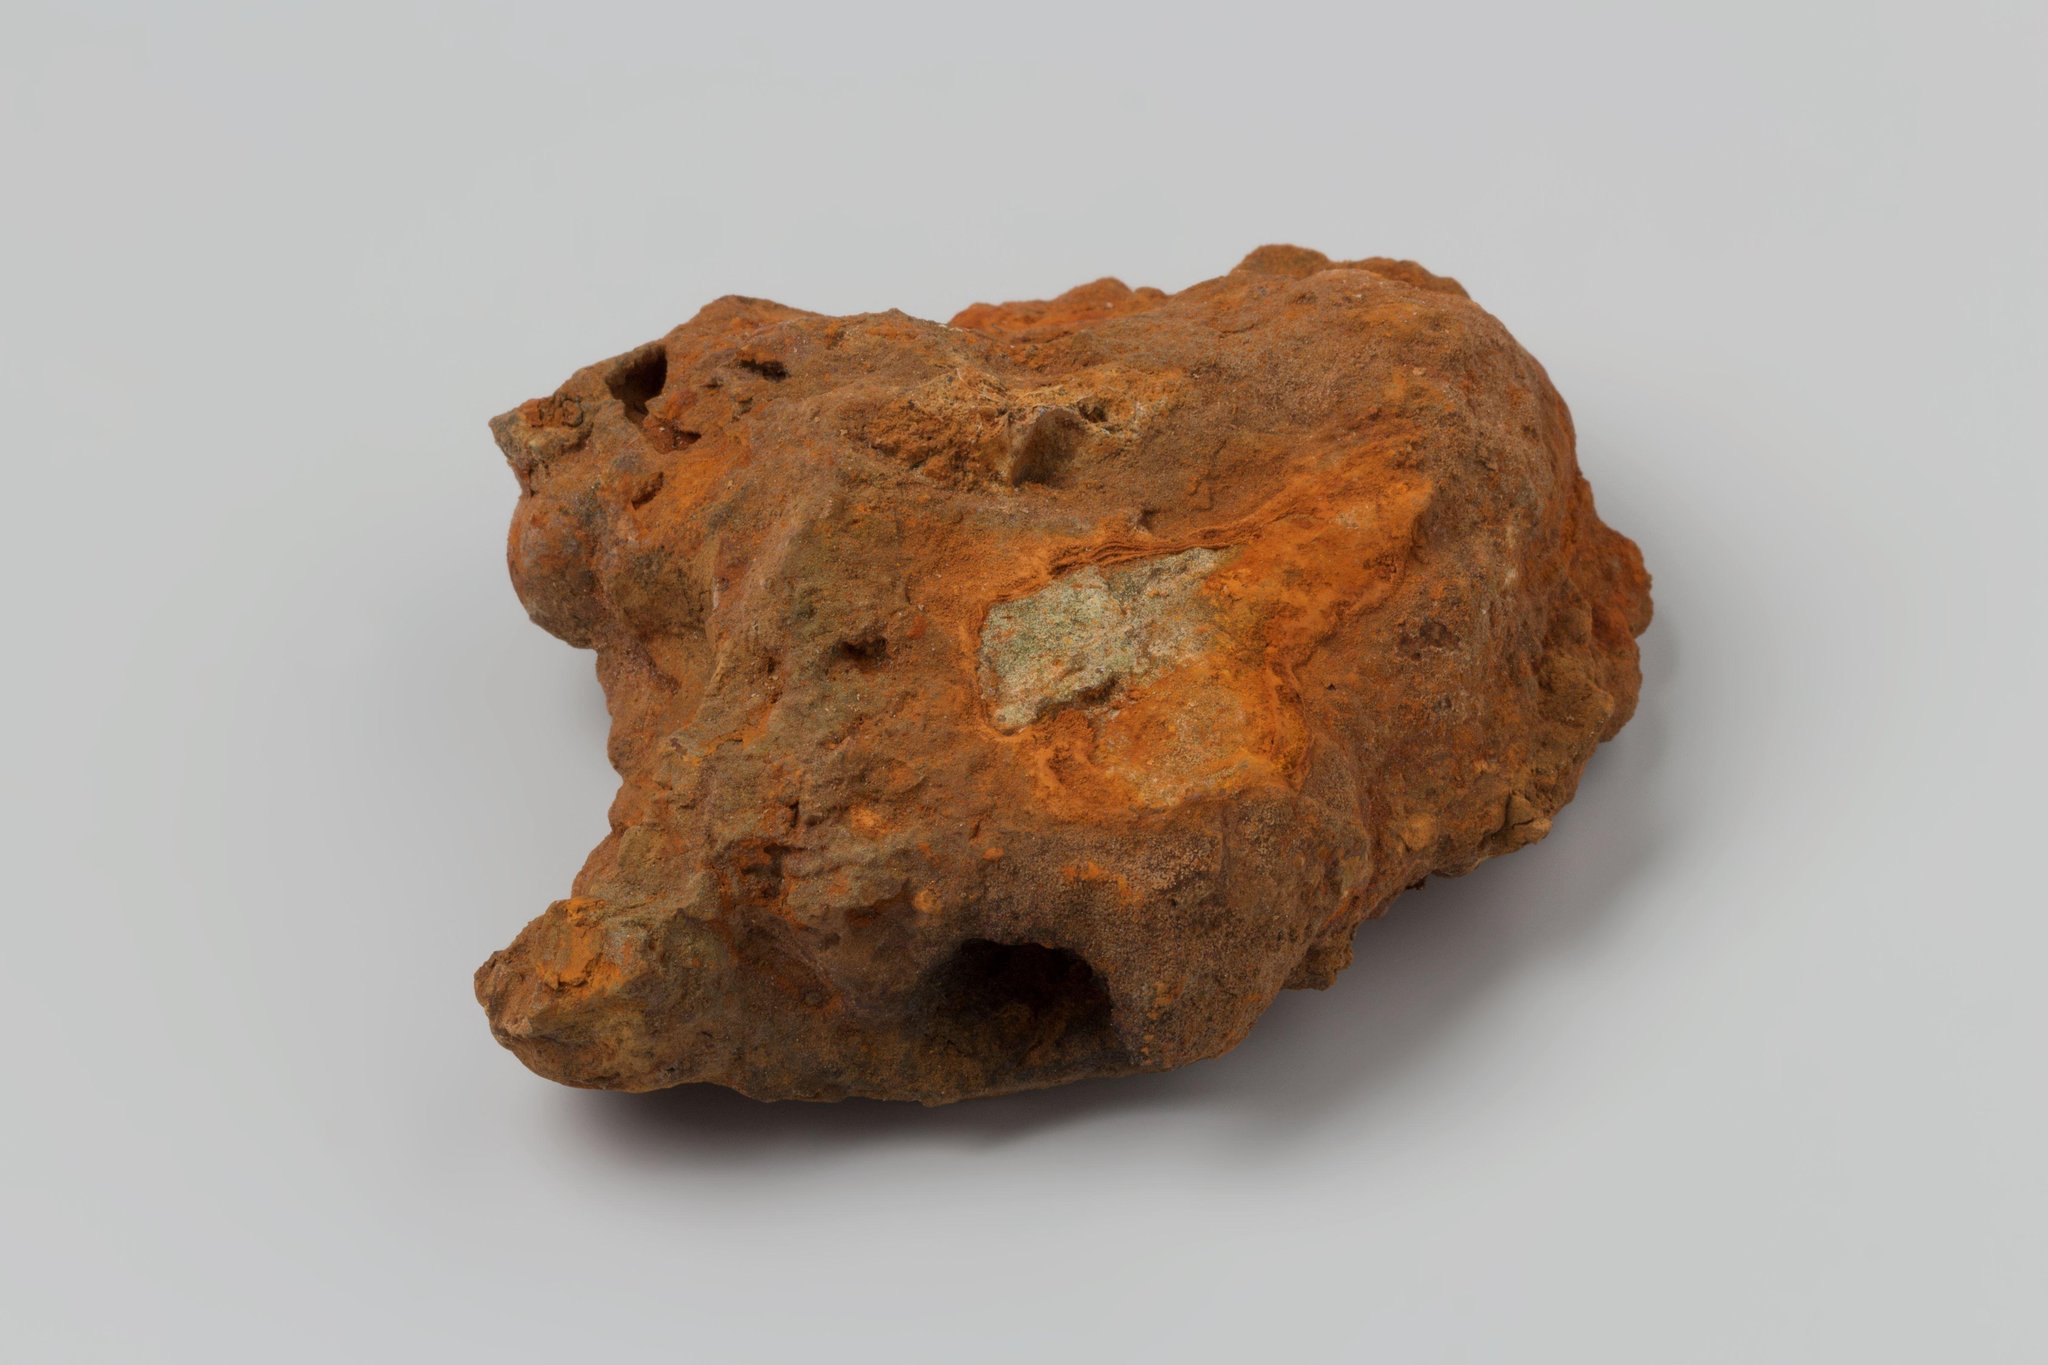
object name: concretionary stone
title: Onbekende vorm in concretie uit het wrak van de Oost-Indiëvaarder 't Vliegend Hart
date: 1700-1735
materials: stone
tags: 't vliegend hart (schip), verenigde oostindische compagnie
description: De concretie is oranje-bruin van kleur. Het is een niet identificeerbaar voorwerp. Concretion.